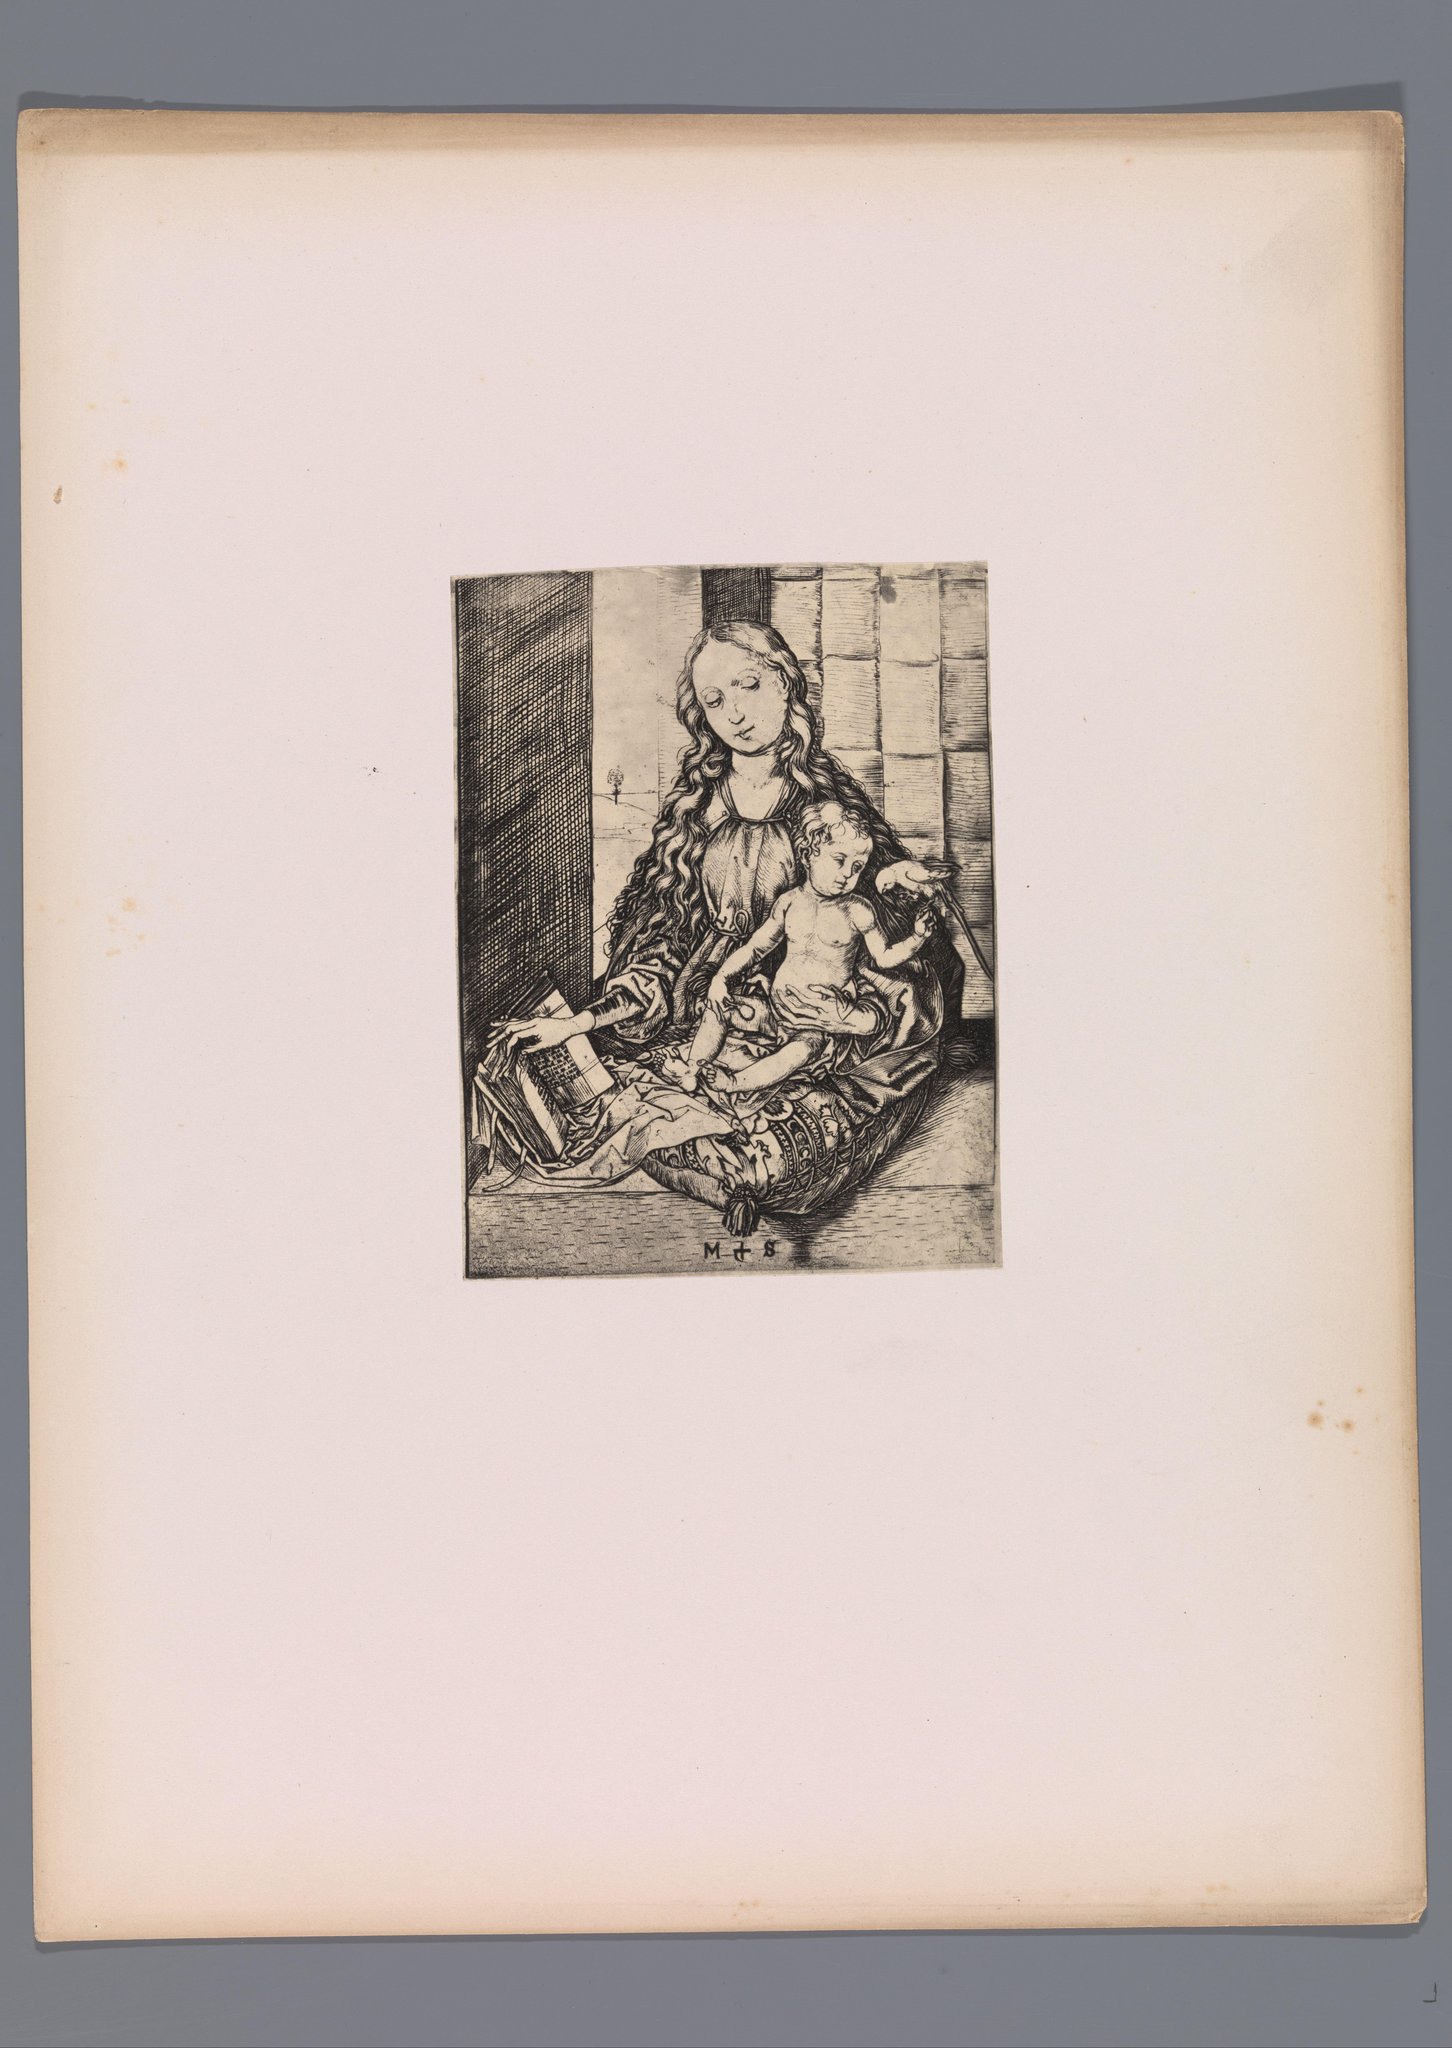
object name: reproduction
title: Reproductie van een prent van Maria met Christus als kind en een boek door Martin Schongauer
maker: martin schongauer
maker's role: print maker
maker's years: 1430-1491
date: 1867-1872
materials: paper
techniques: woodburytype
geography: brussels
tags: mary sitting on the ground, the christ-child in front of her, sitting in her lap, book - mm - book open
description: Deze prent maakt deel uit van een omslag met 24 prenten op 24 bladen.